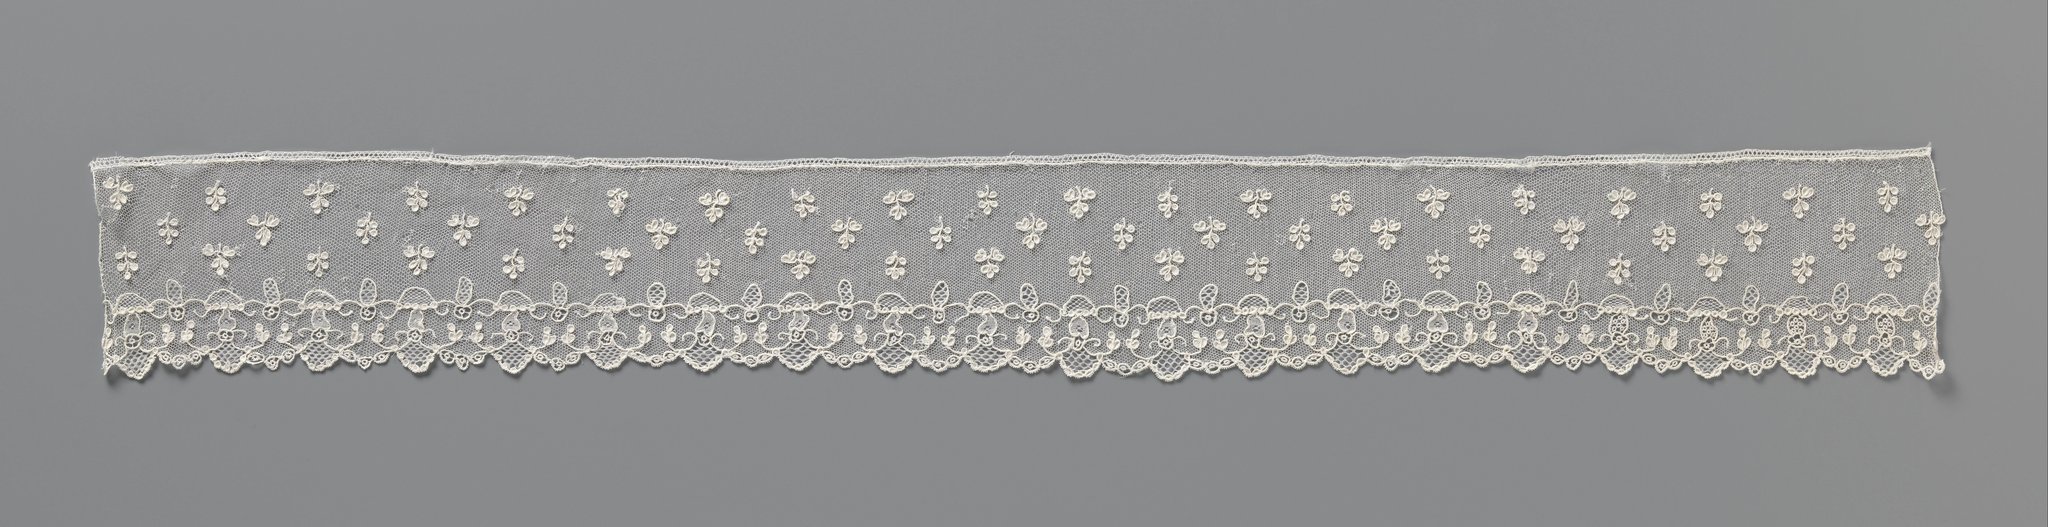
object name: strip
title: Strook naaldkant met paddenstoeltjes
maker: Anonymous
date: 1795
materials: linen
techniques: lace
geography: alençon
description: Strook naturelkleurige naaldkant: Alençon-kant. Onder een strooipatroon van drie rijen hangende bloemtakjes bestaat het zich herhalende en doorlopende patroon langs de onderzijde van de strook uit paddenstoeltjes, afgewisseld met een ijle voluut met in het centrum een cirkeltje bekroond door een staand ovaaltje. De schulpenrand wordt gevormd door waaiervormig motiefjes, onder elke paddenstoel één. De waaiertjes zijn met elkaar verbonden door een slingertje van drie cirkeltjes met raderpicots erin. De motieven zijn met elkaar verbonden door een fijne zeshoekige maasgrond, een Alençon-grond met opgehaalde festonsteken. Het spaarzame volwerk is gemaakt met festonsteken, de motieven zijn voorzien van reliëfcontouren. Enkele verschillende fijne siergronden zijn toegepast in de motieven in het patroon aan de onderzijde van de strook. De bovenzijde van de strook is afgewerkt met een apart geklost bandje. De schulpen langs de onderzijde zijn afgewerkt met picots.